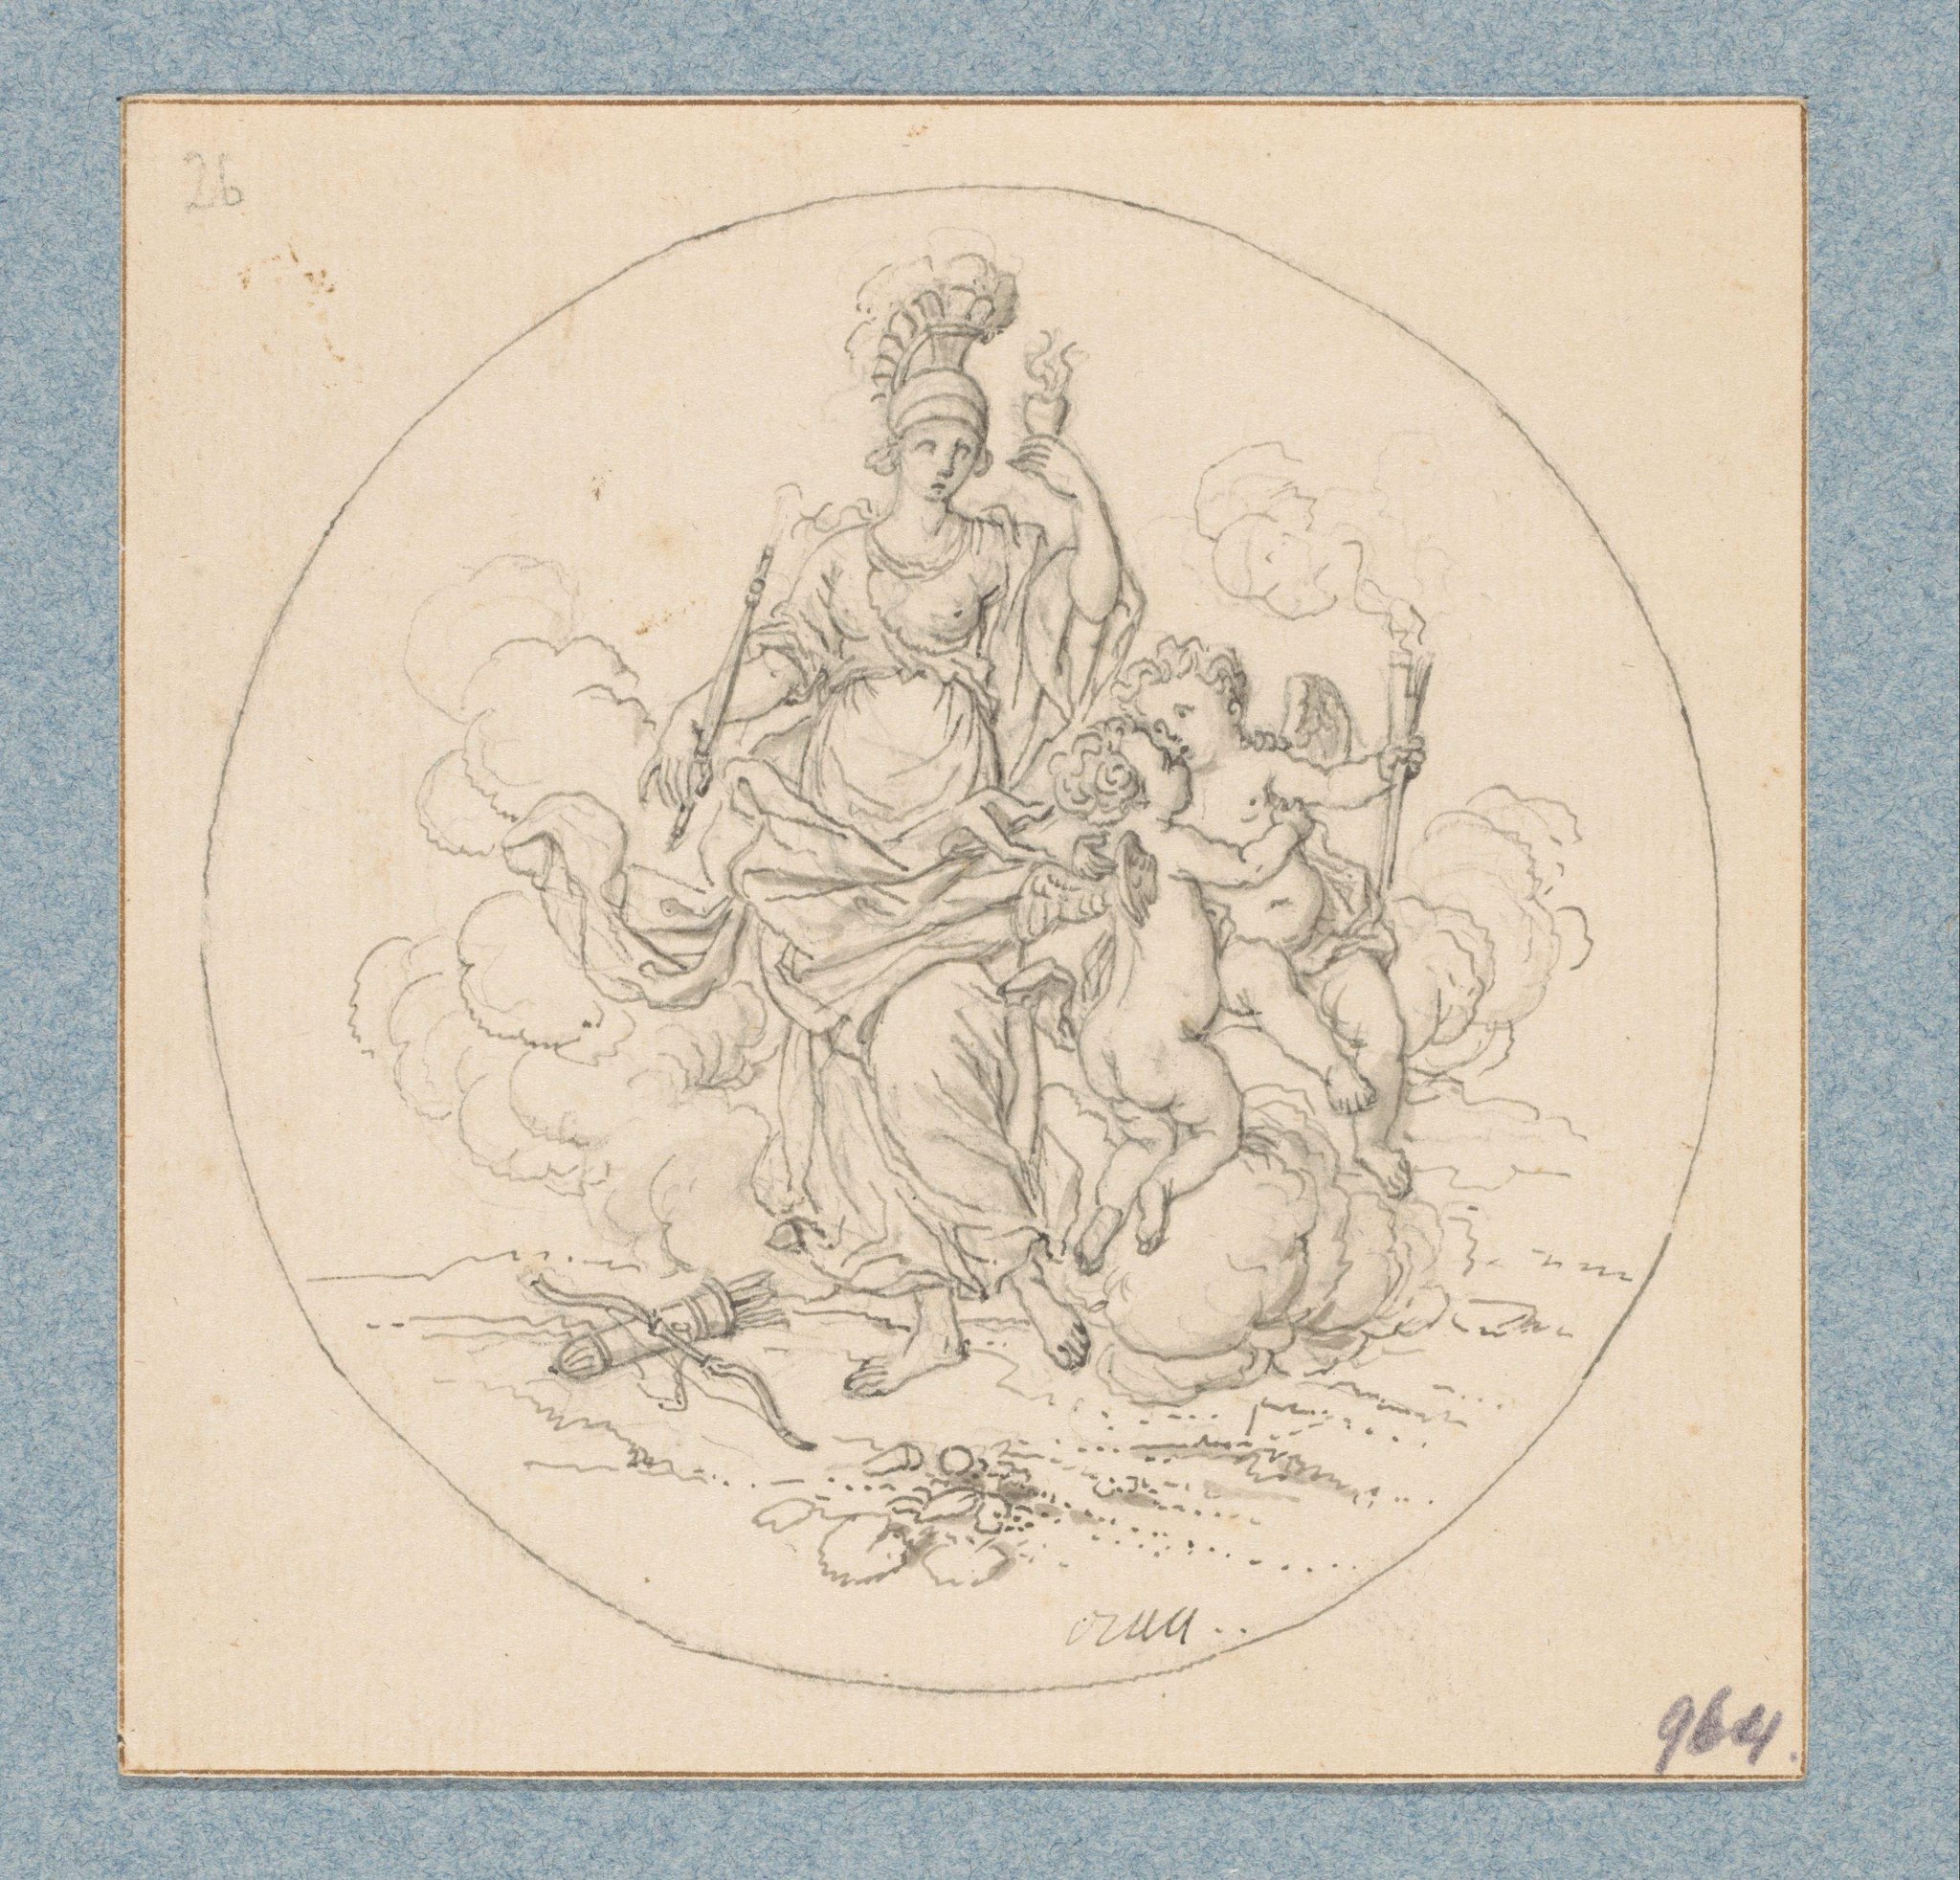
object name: drawing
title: Allegorie op de Liefde (in doos met 43 tekeningen)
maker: louis fabritius dubourg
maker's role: draughtsman, print maker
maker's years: 1693-1775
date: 1744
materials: ink, paper, pencil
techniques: brush, pen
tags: (personifications and symbolic representations of) love; 'amore (secondo seneca)' (ripa) (+ allegorical scene, i.e. two or more personifications involved in an action)